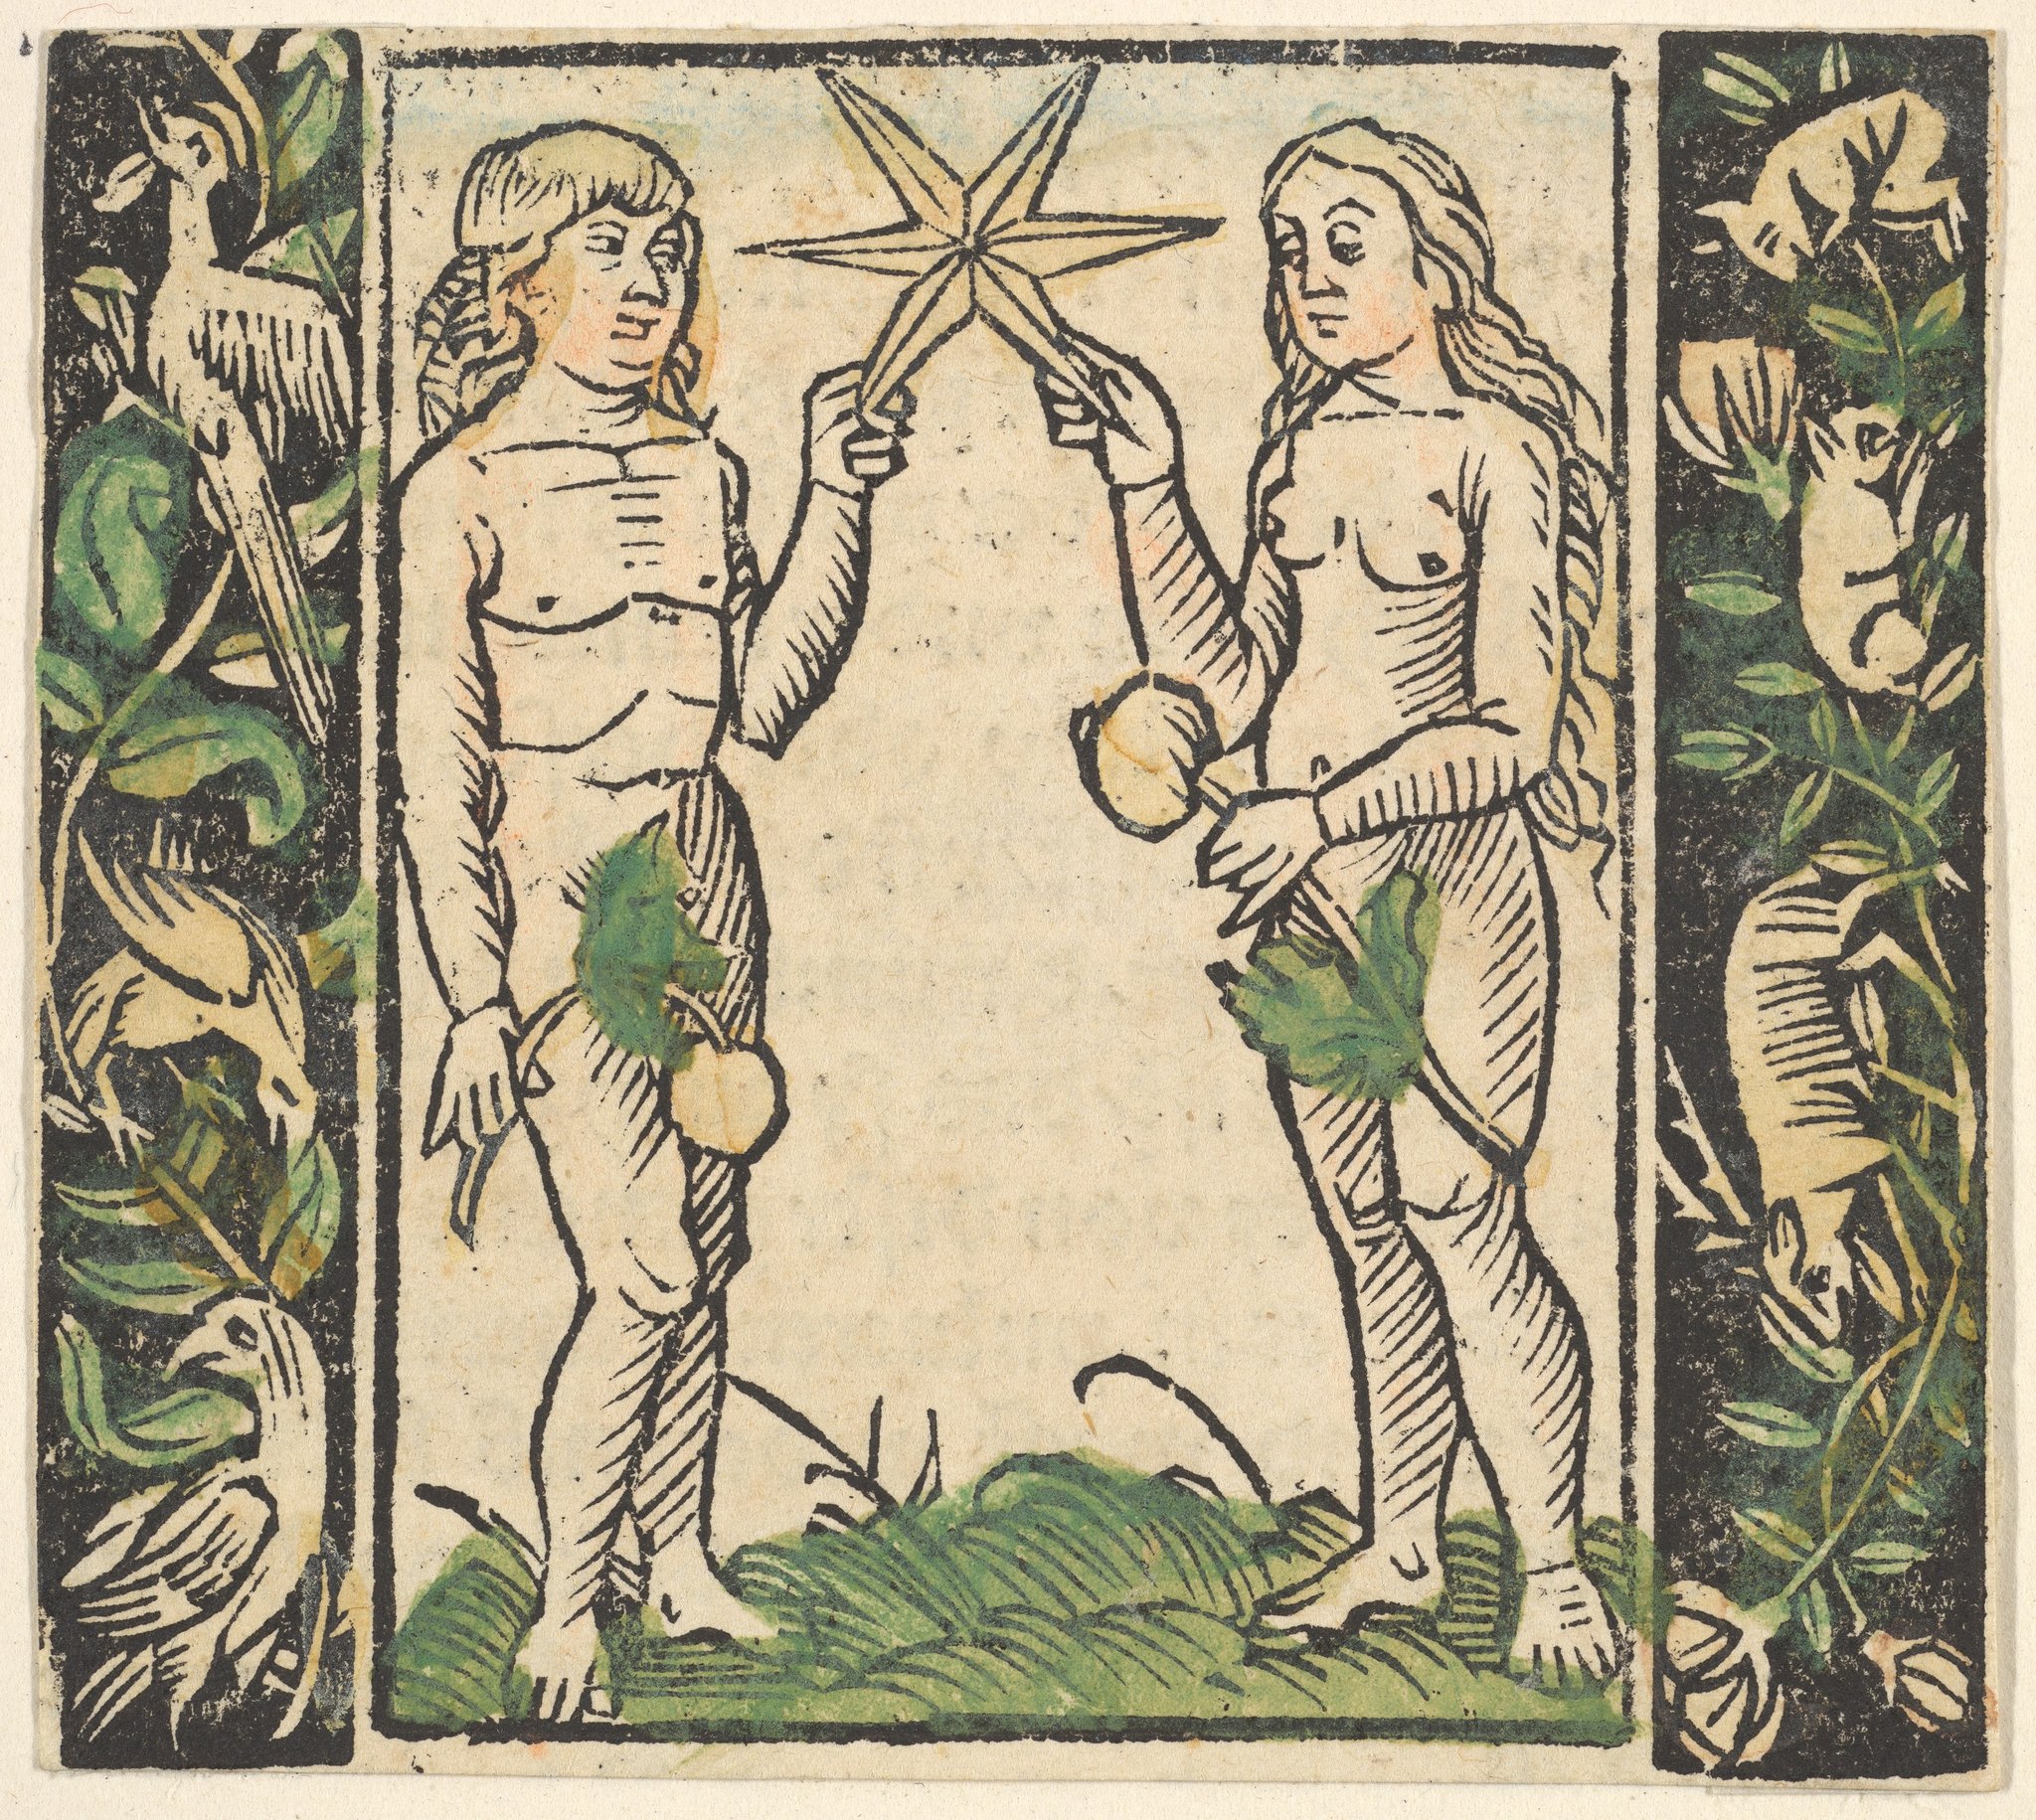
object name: print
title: Adam and Eve Holding a Star, illustration from Beschlossen Gart des Rosenkranz Mariae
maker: hans baldung (called hans baldung grien)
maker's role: artist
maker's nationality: german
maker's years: 1484-1545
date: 1500-1545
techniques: hand coloring, woodcut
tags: birds,rabbits,stars,adam,eve